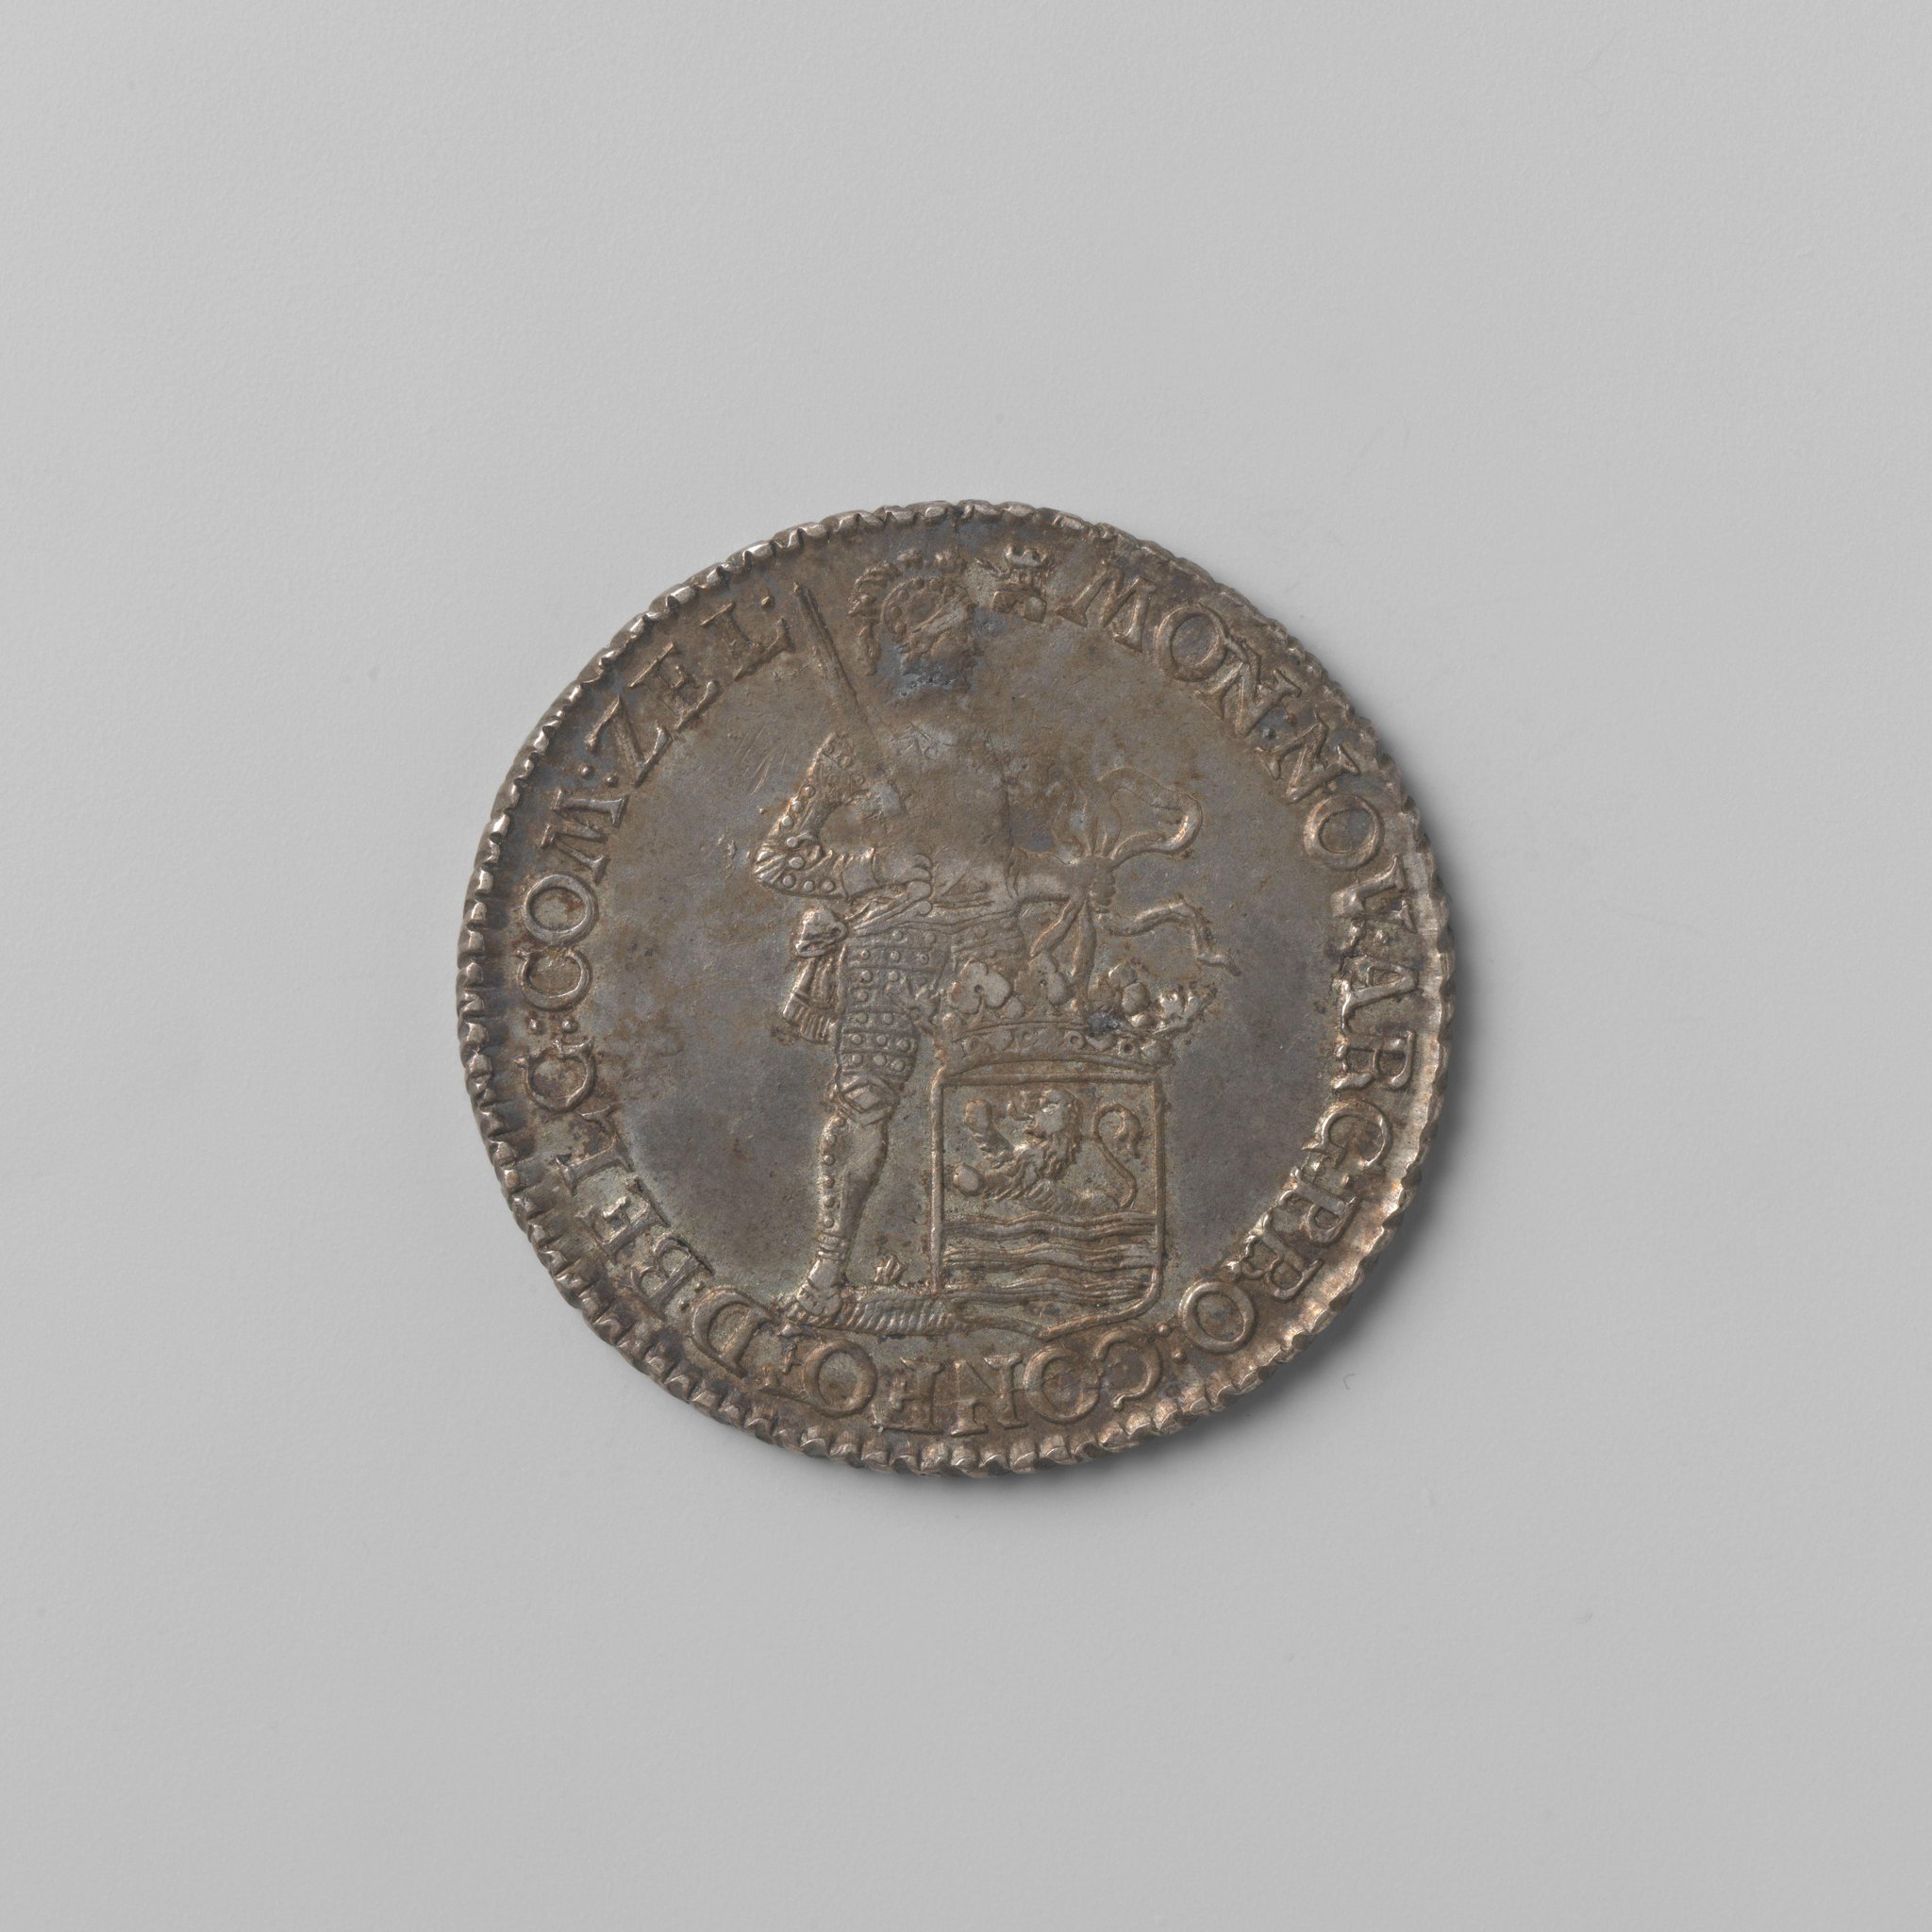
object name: coin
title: Zeeuwse halve zilveren dukaat, 1786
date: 1786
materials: silver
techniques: striking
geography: middelburg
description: Zilveren munt. Voorzijde: staande geharnaste ridder naar rechts met zwaard in rechterhand en gekroond wapenschild van Zeeland aan lint in linkerhand. Keerzijde: tussen jaartal gekroond generaliteitswapenschild. Kabelrand.